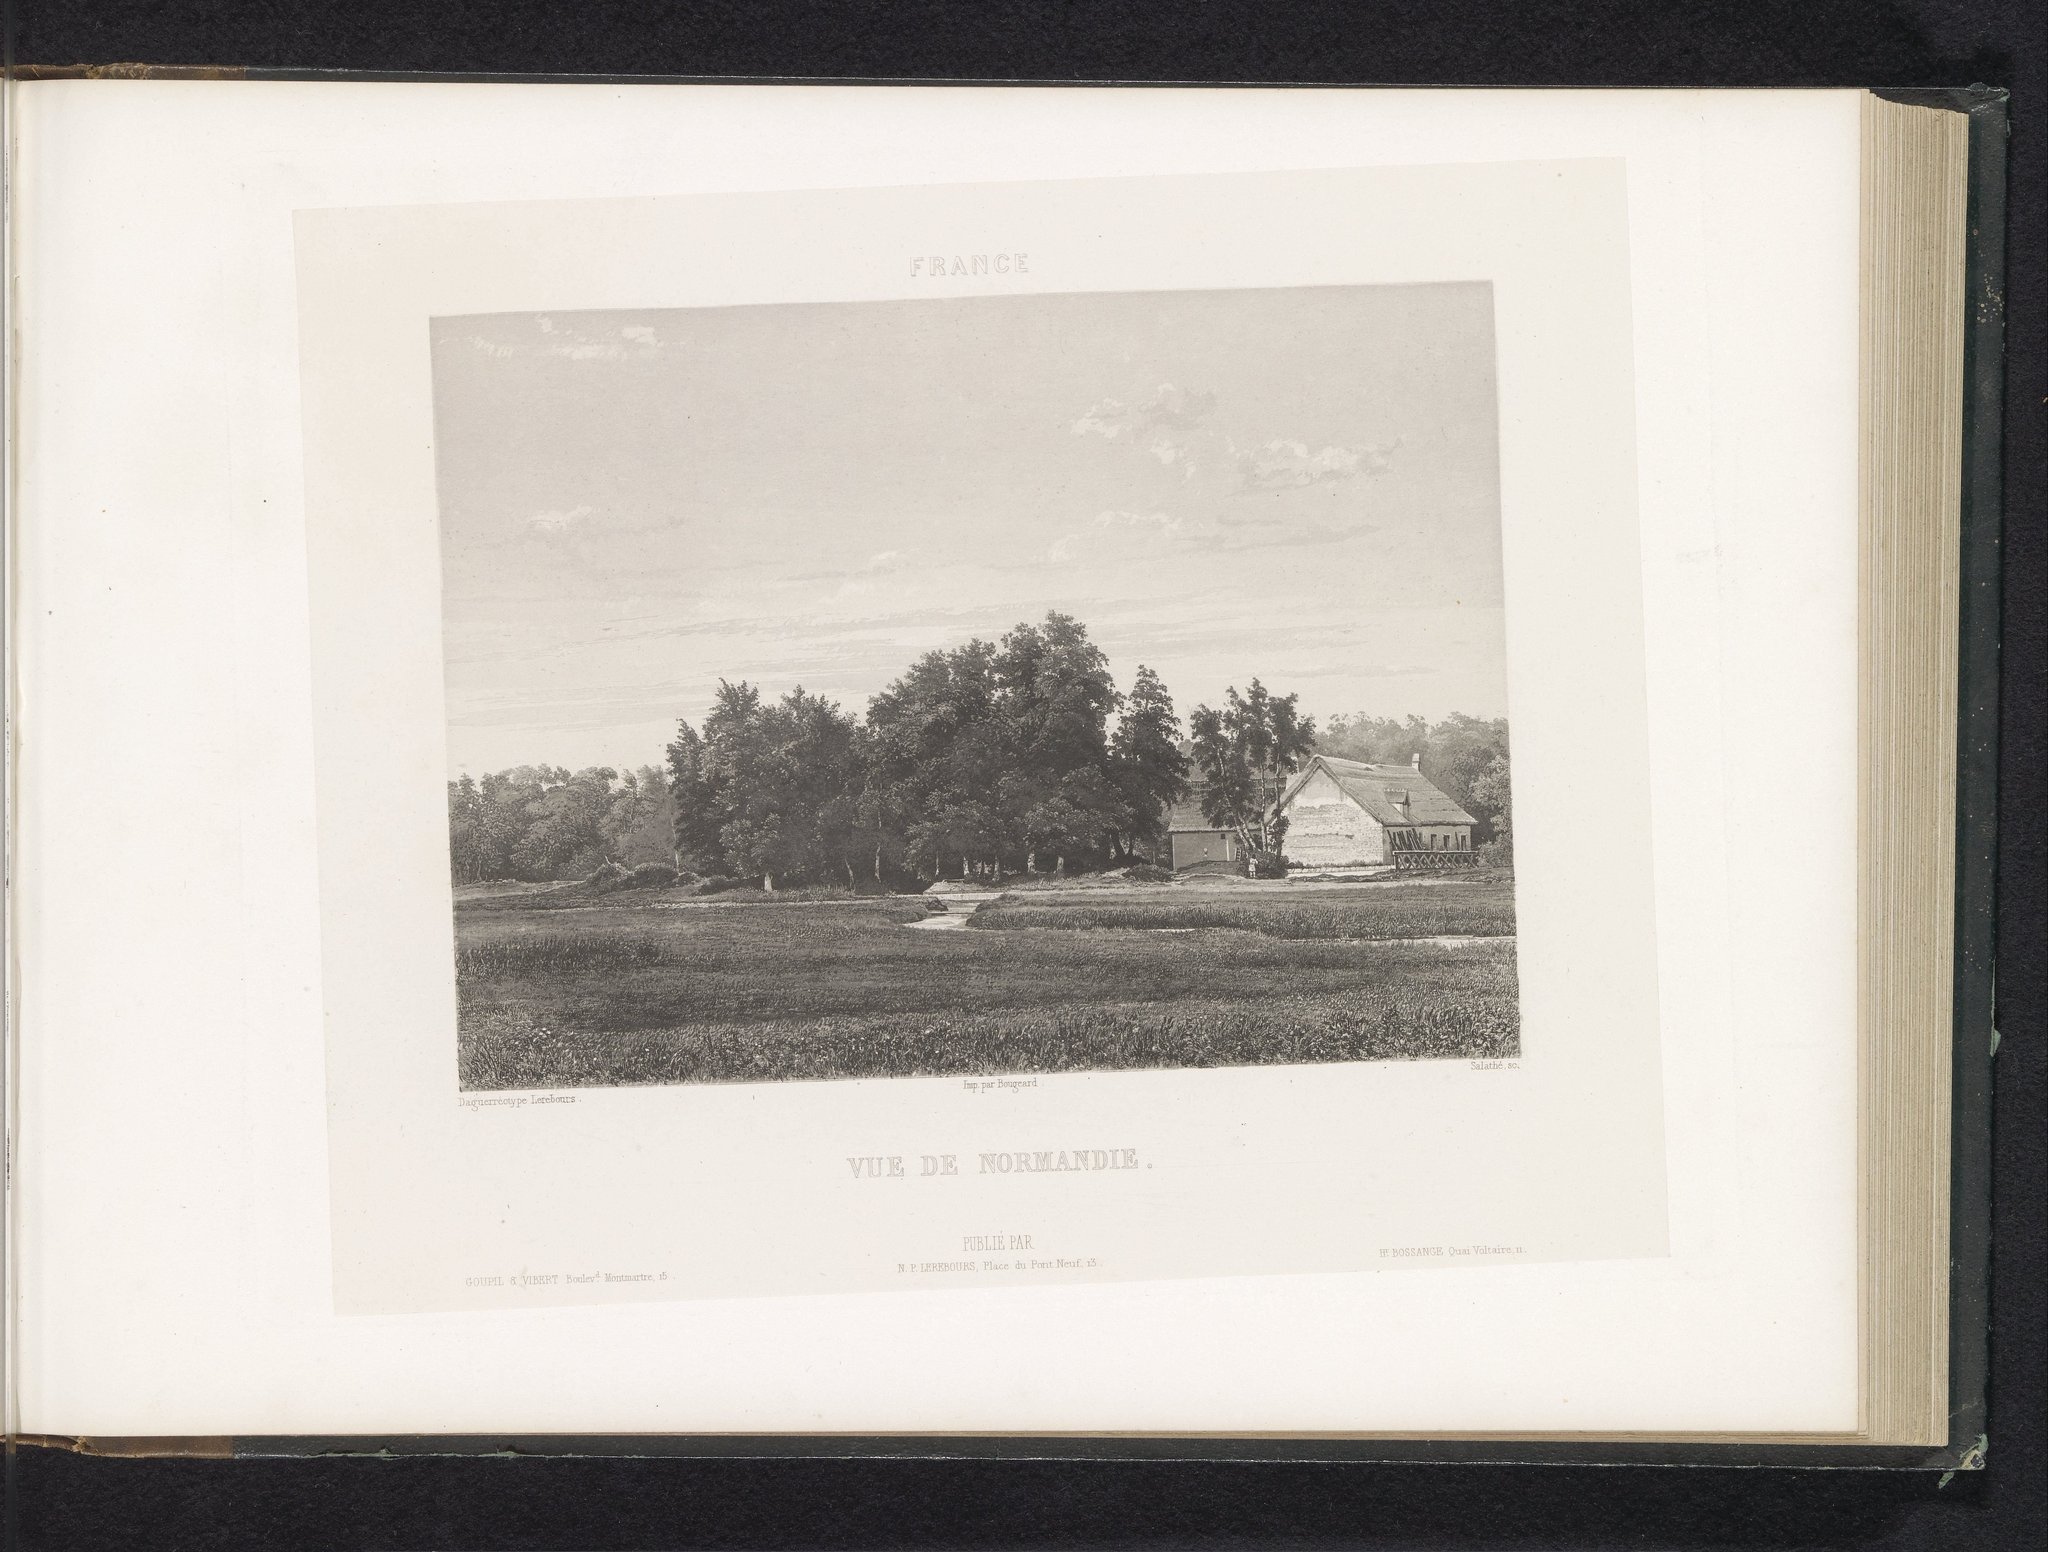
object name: print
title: Vue de Normandie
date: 1839-1841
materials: paper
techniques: aquatint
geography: paris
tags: farm or solitary house in landscape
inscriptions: inscription: ‘Hr. Bossance Quai Voltaire 11’, inscription: ‘Rittner & Goupil Boulevd Montmartre 15’, inscription: ‘N.P. Lerebours Place du Pont Neuf 15’